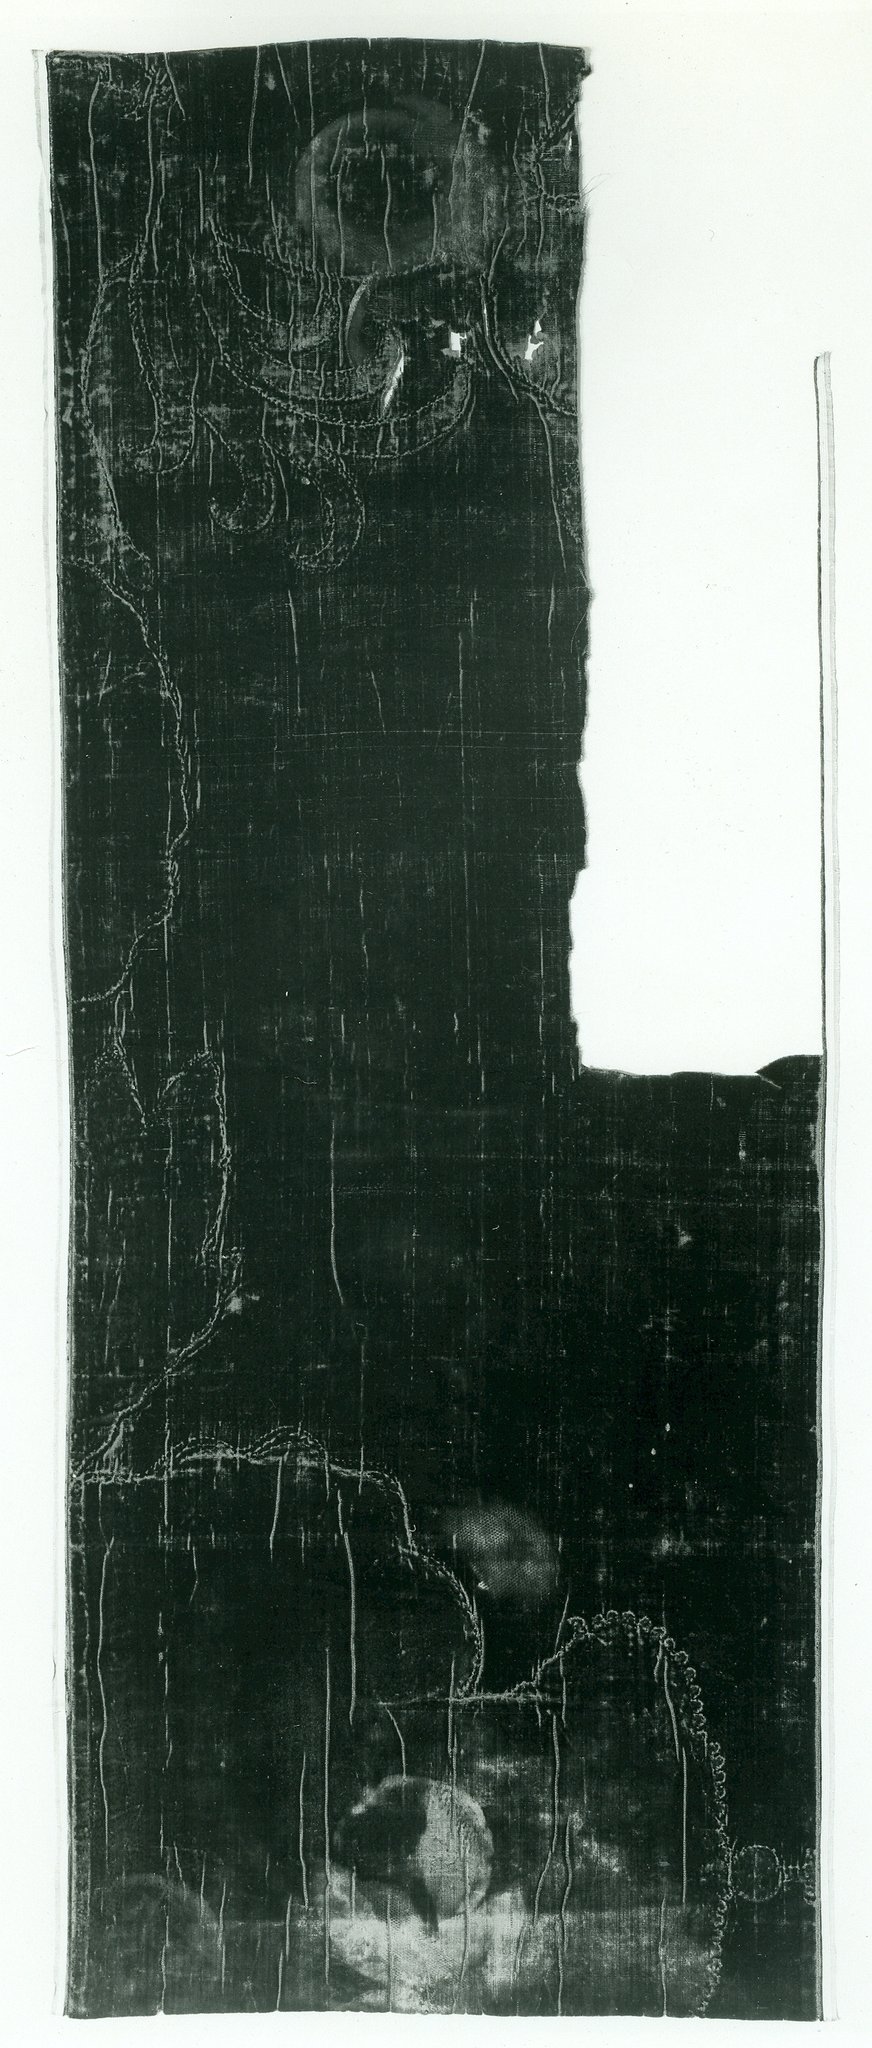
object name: textile fragment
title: Fragment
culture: italian or spanish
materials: silk